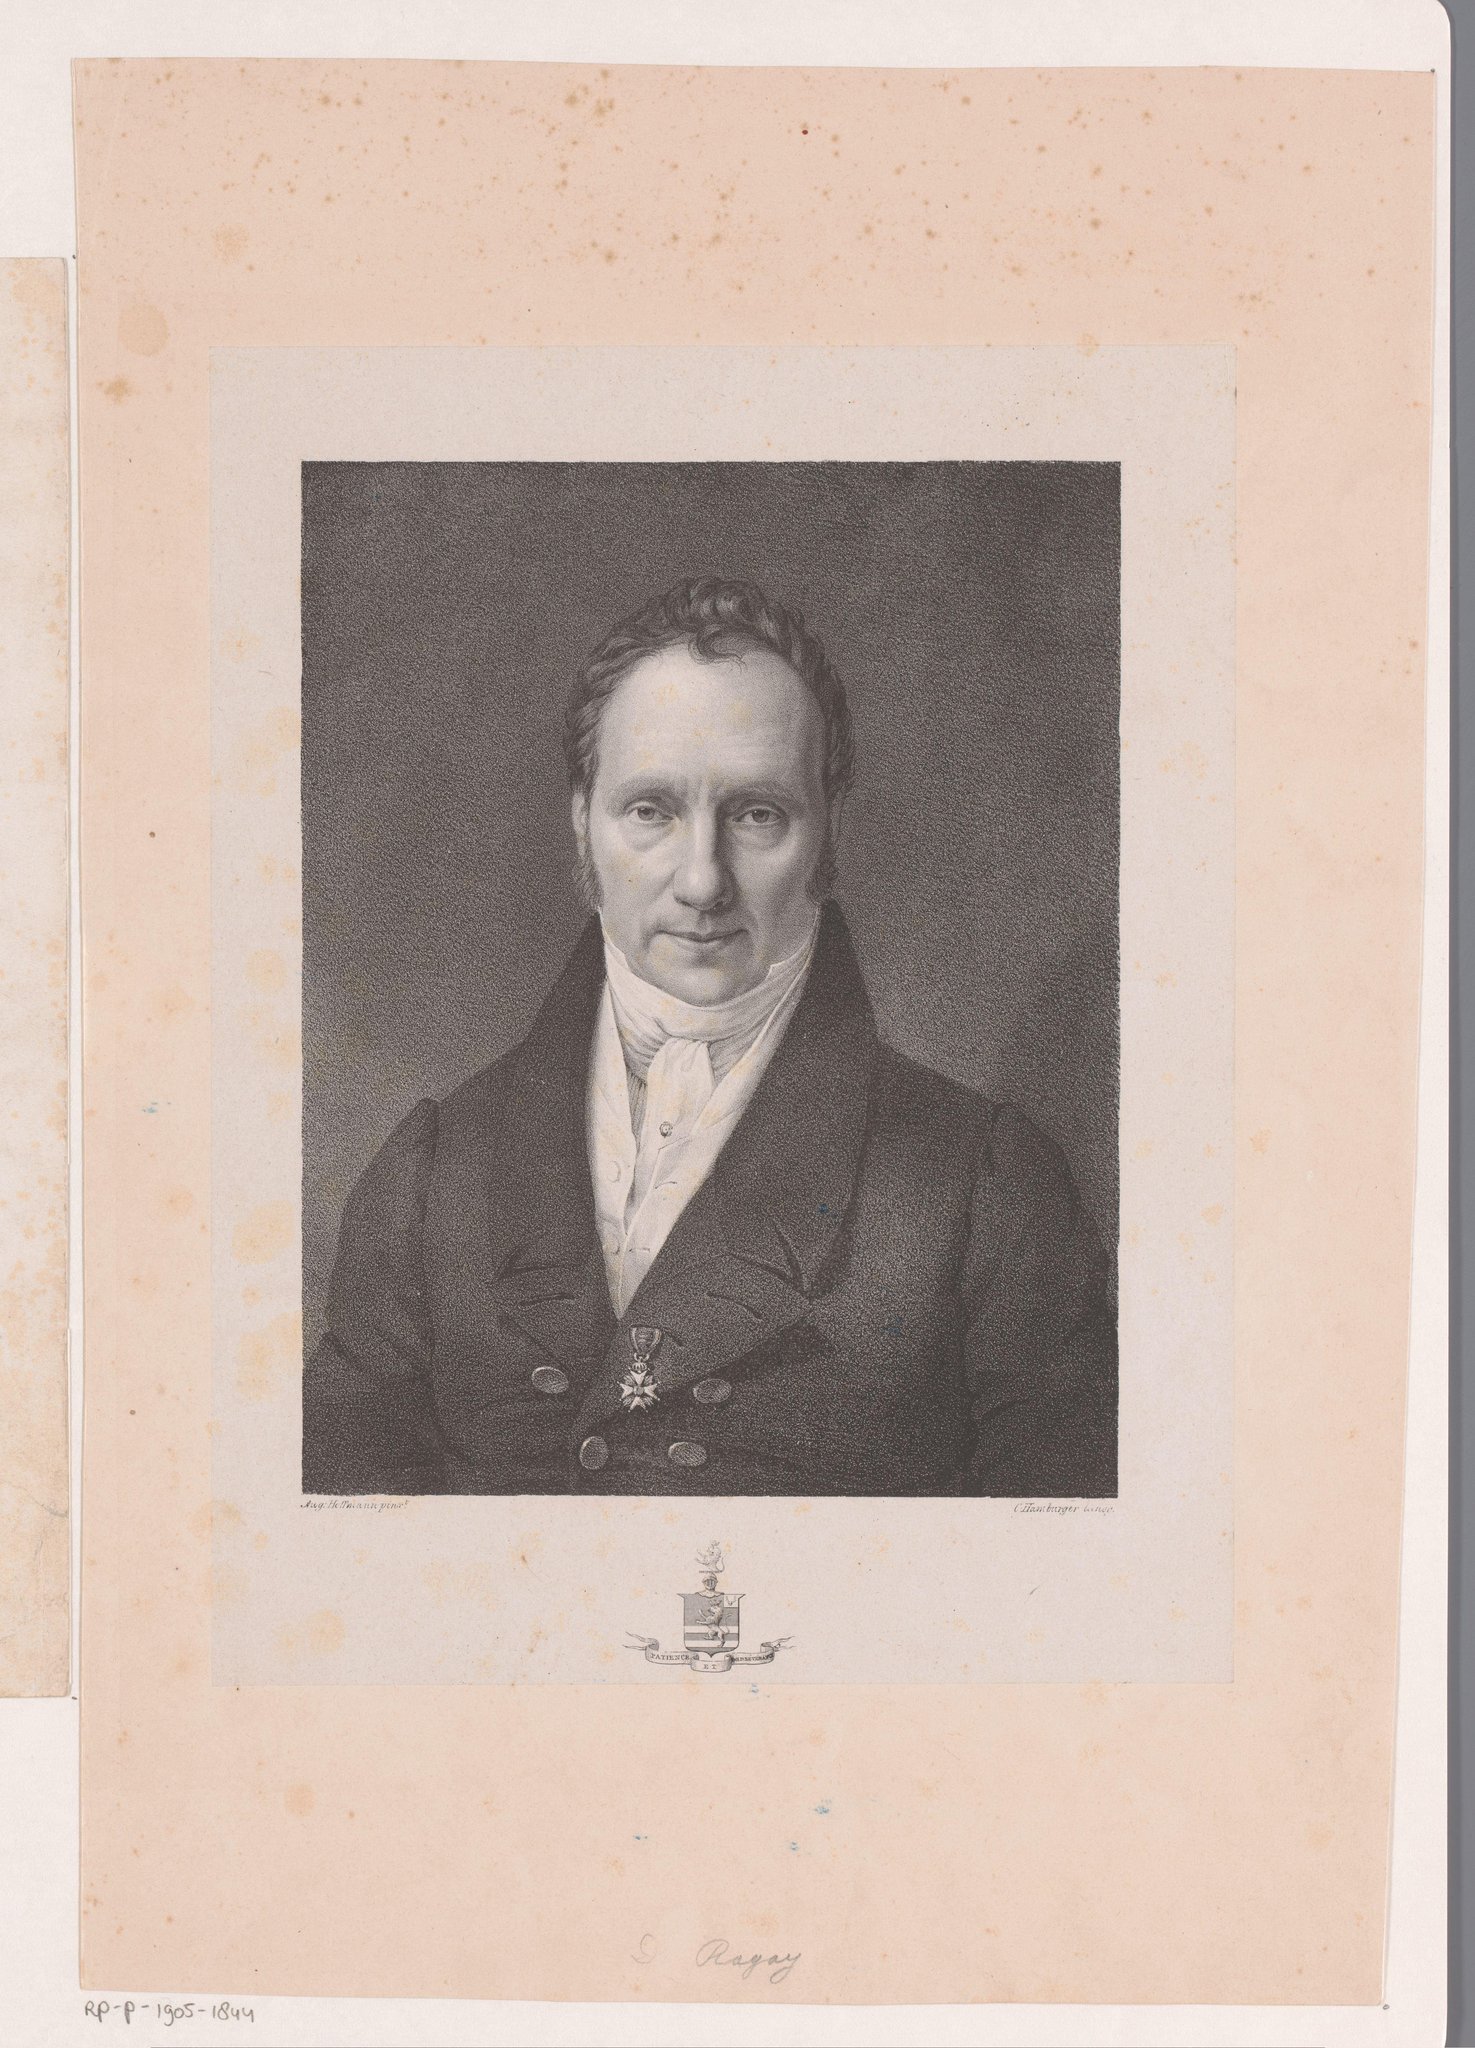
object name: print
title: Portret van D. Ragay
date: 1819-1853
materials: paper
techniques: lithograph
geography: munich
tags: knighthood order, historical persons (+ (full) bust portrait)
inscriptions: collector's mark: Lugt 2228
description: De geportretteerde draagt een ridderorde in een knoopsgat van zijn jas. Onder het portret zijn familiewapen.